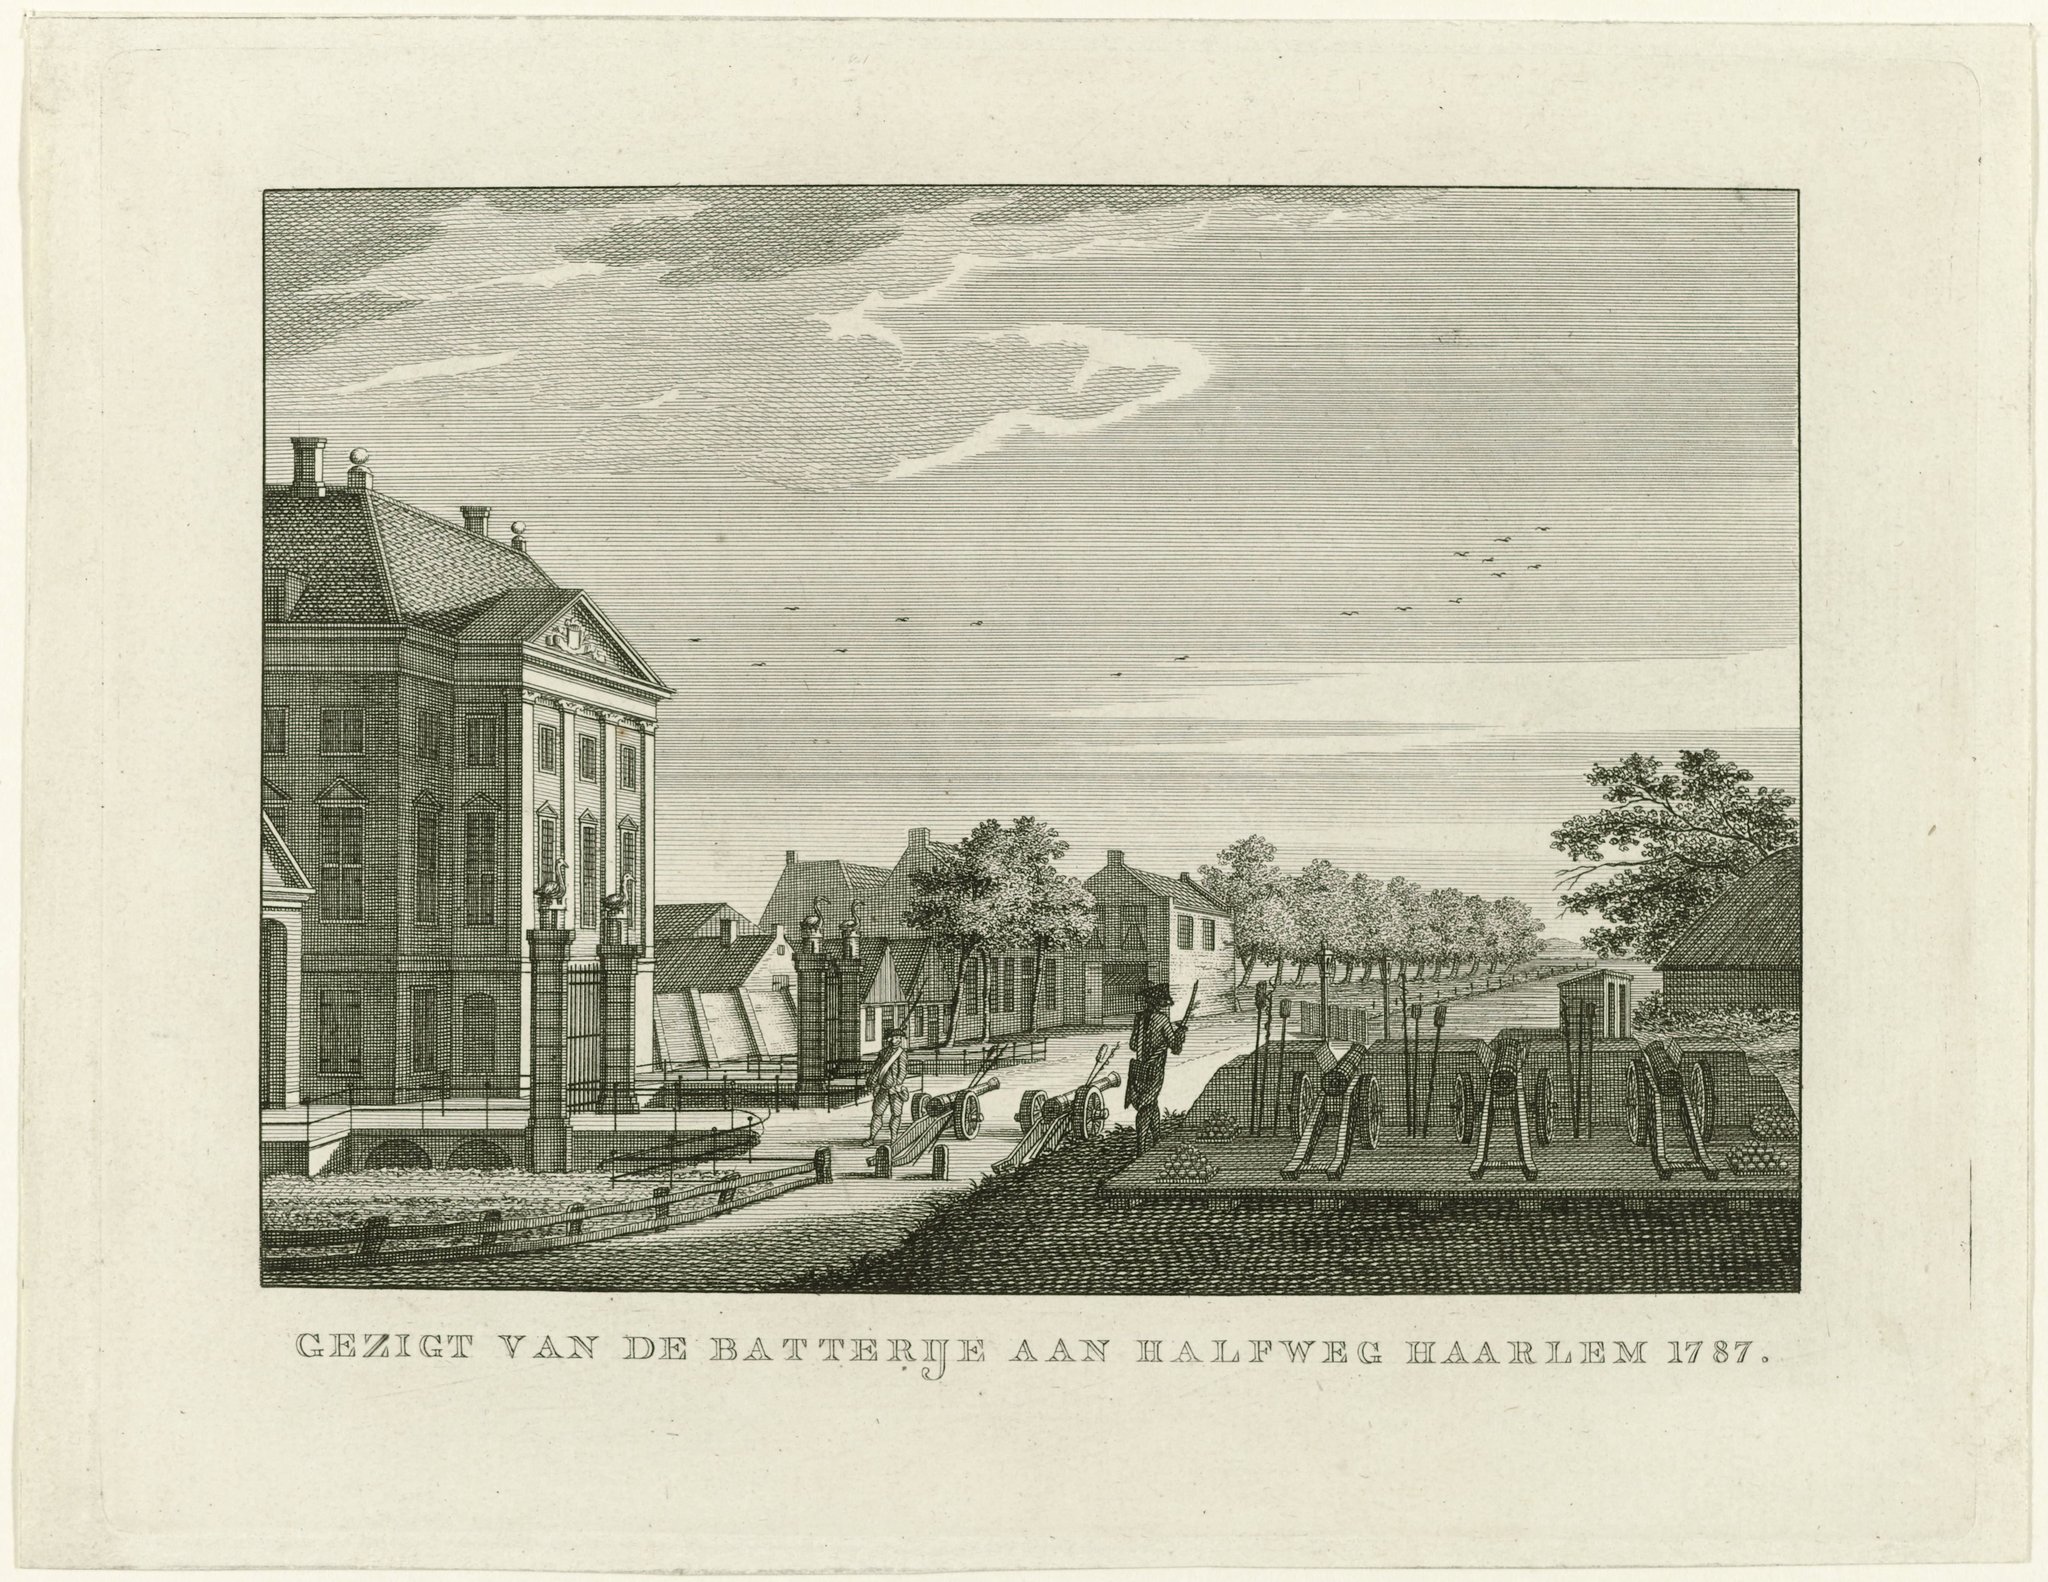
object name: print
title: Gezigt van de batterije aan Halfweg Haarlem 1787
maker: Anonymous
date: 1787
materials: paper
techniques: etching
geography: northern netherlands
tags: defence of fortification or city, defensive measures (military)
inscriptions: collector's mark: Lugt 2228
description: Battterij te Halfweg, links het Huis Zwanenburg, gemeenlandshuis van het Hoogheemraadschap van Rijnland. Onderdeel van een serie van veertien platen van de verdedigingen aangelegd door de patriotten rondom Amsterdam ten tijde van de inval van de Pruisische troepen in september 1787.